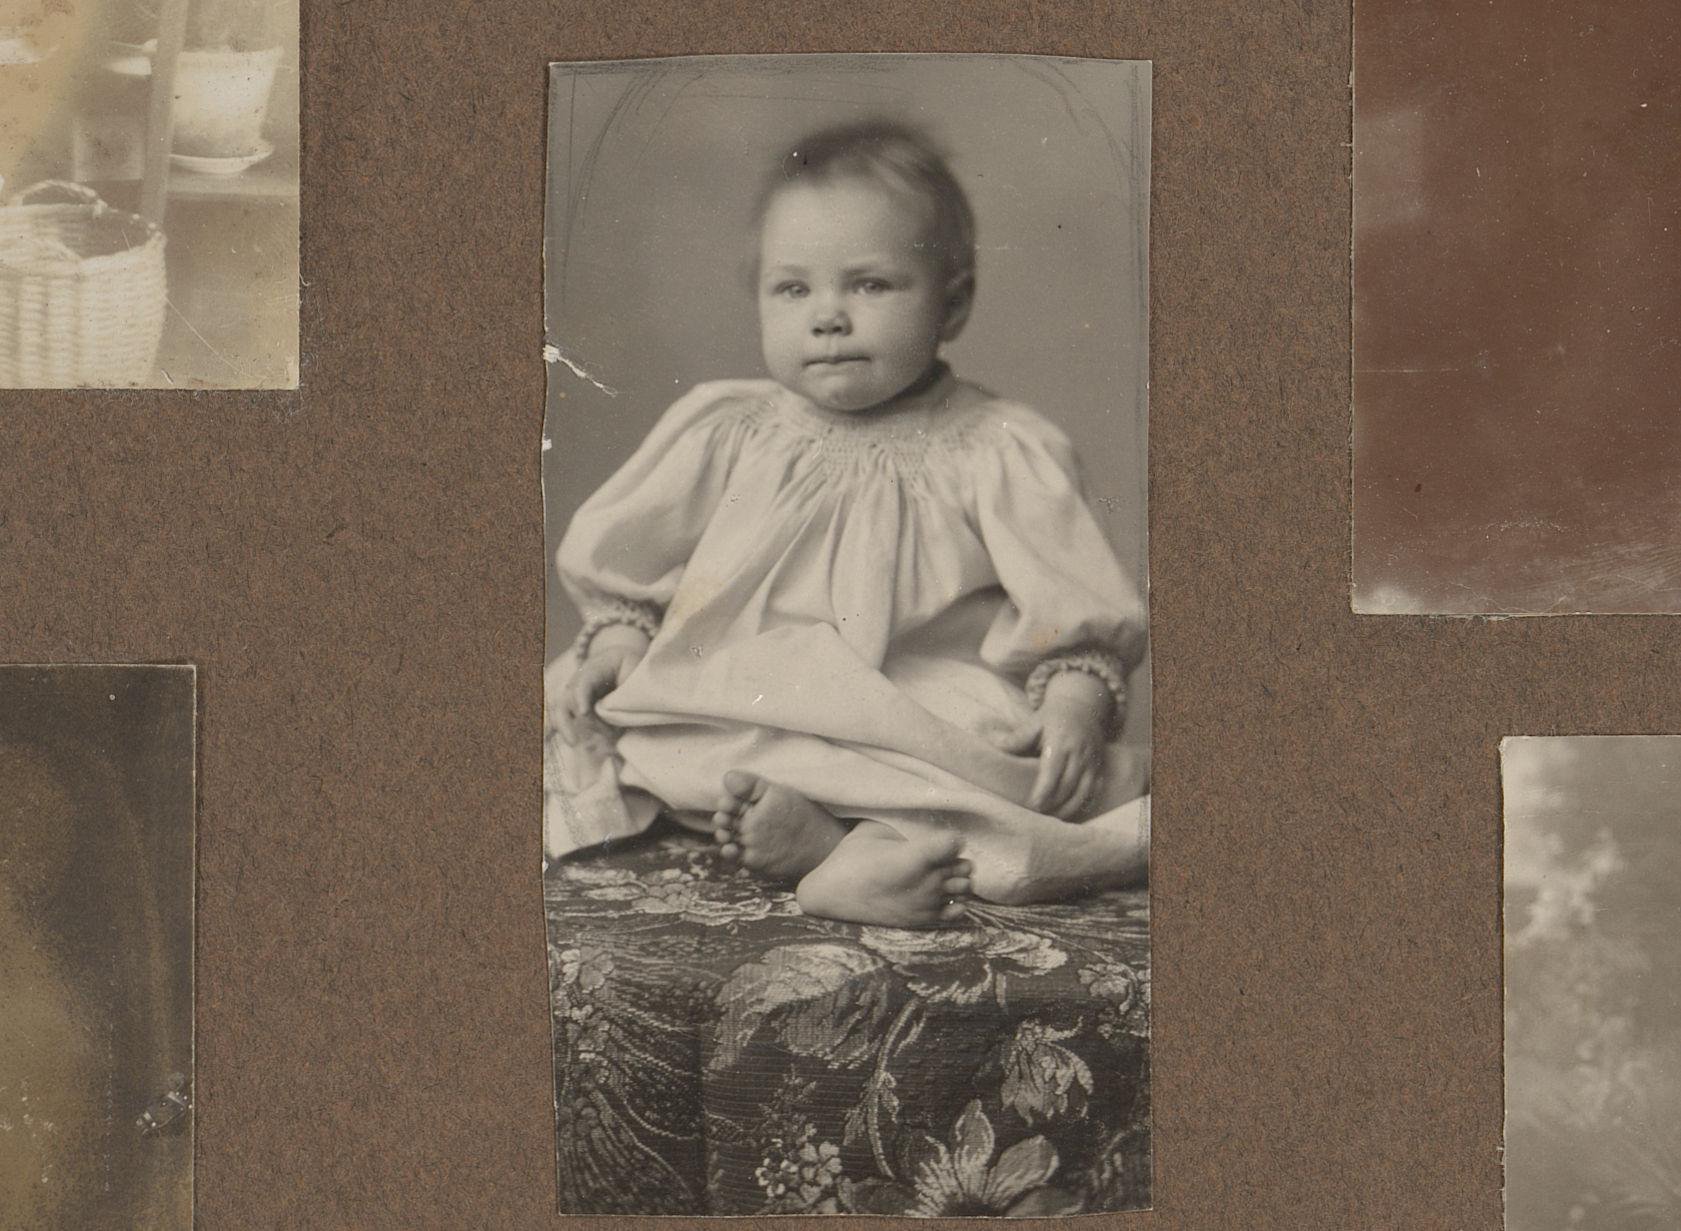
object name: photograph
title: Jong zittend kind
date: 1870-1920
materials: photographic support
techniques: photography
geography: netherlands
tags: netherlands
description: Foto op bruin albumblad 43 van familiealbum van Alphons Diepenbrock.